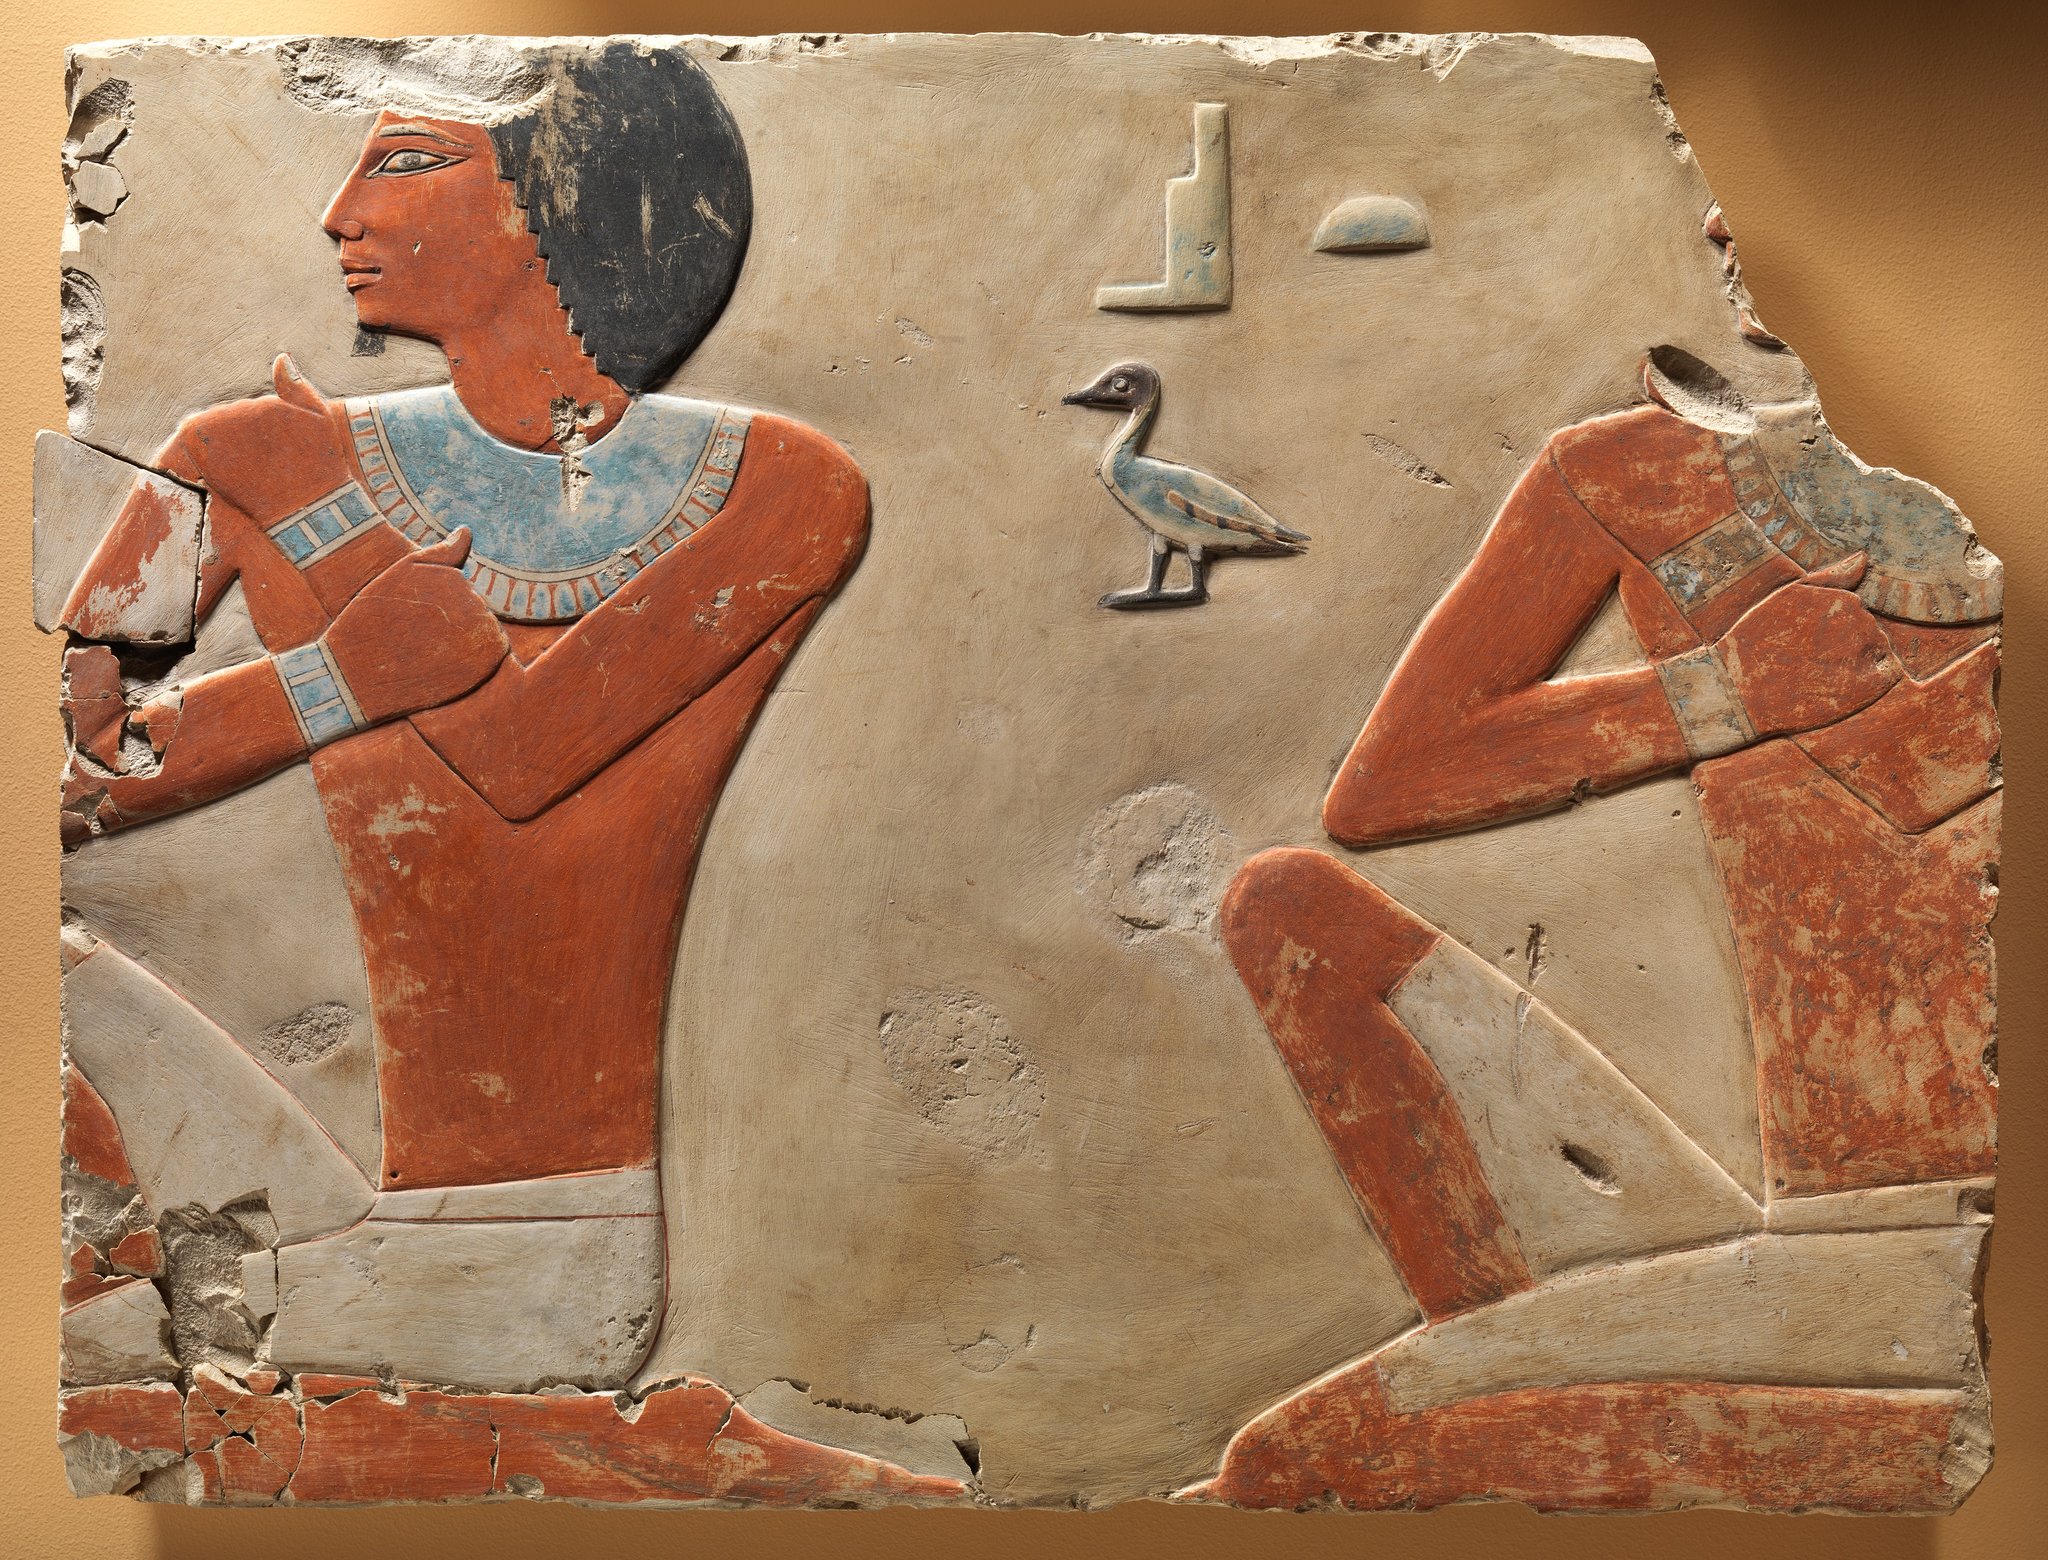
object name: relief, tomb of dagi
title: Relief with two officials or sons of the Vizier Dagi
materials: limestone, paint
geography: egypt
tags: birds,men